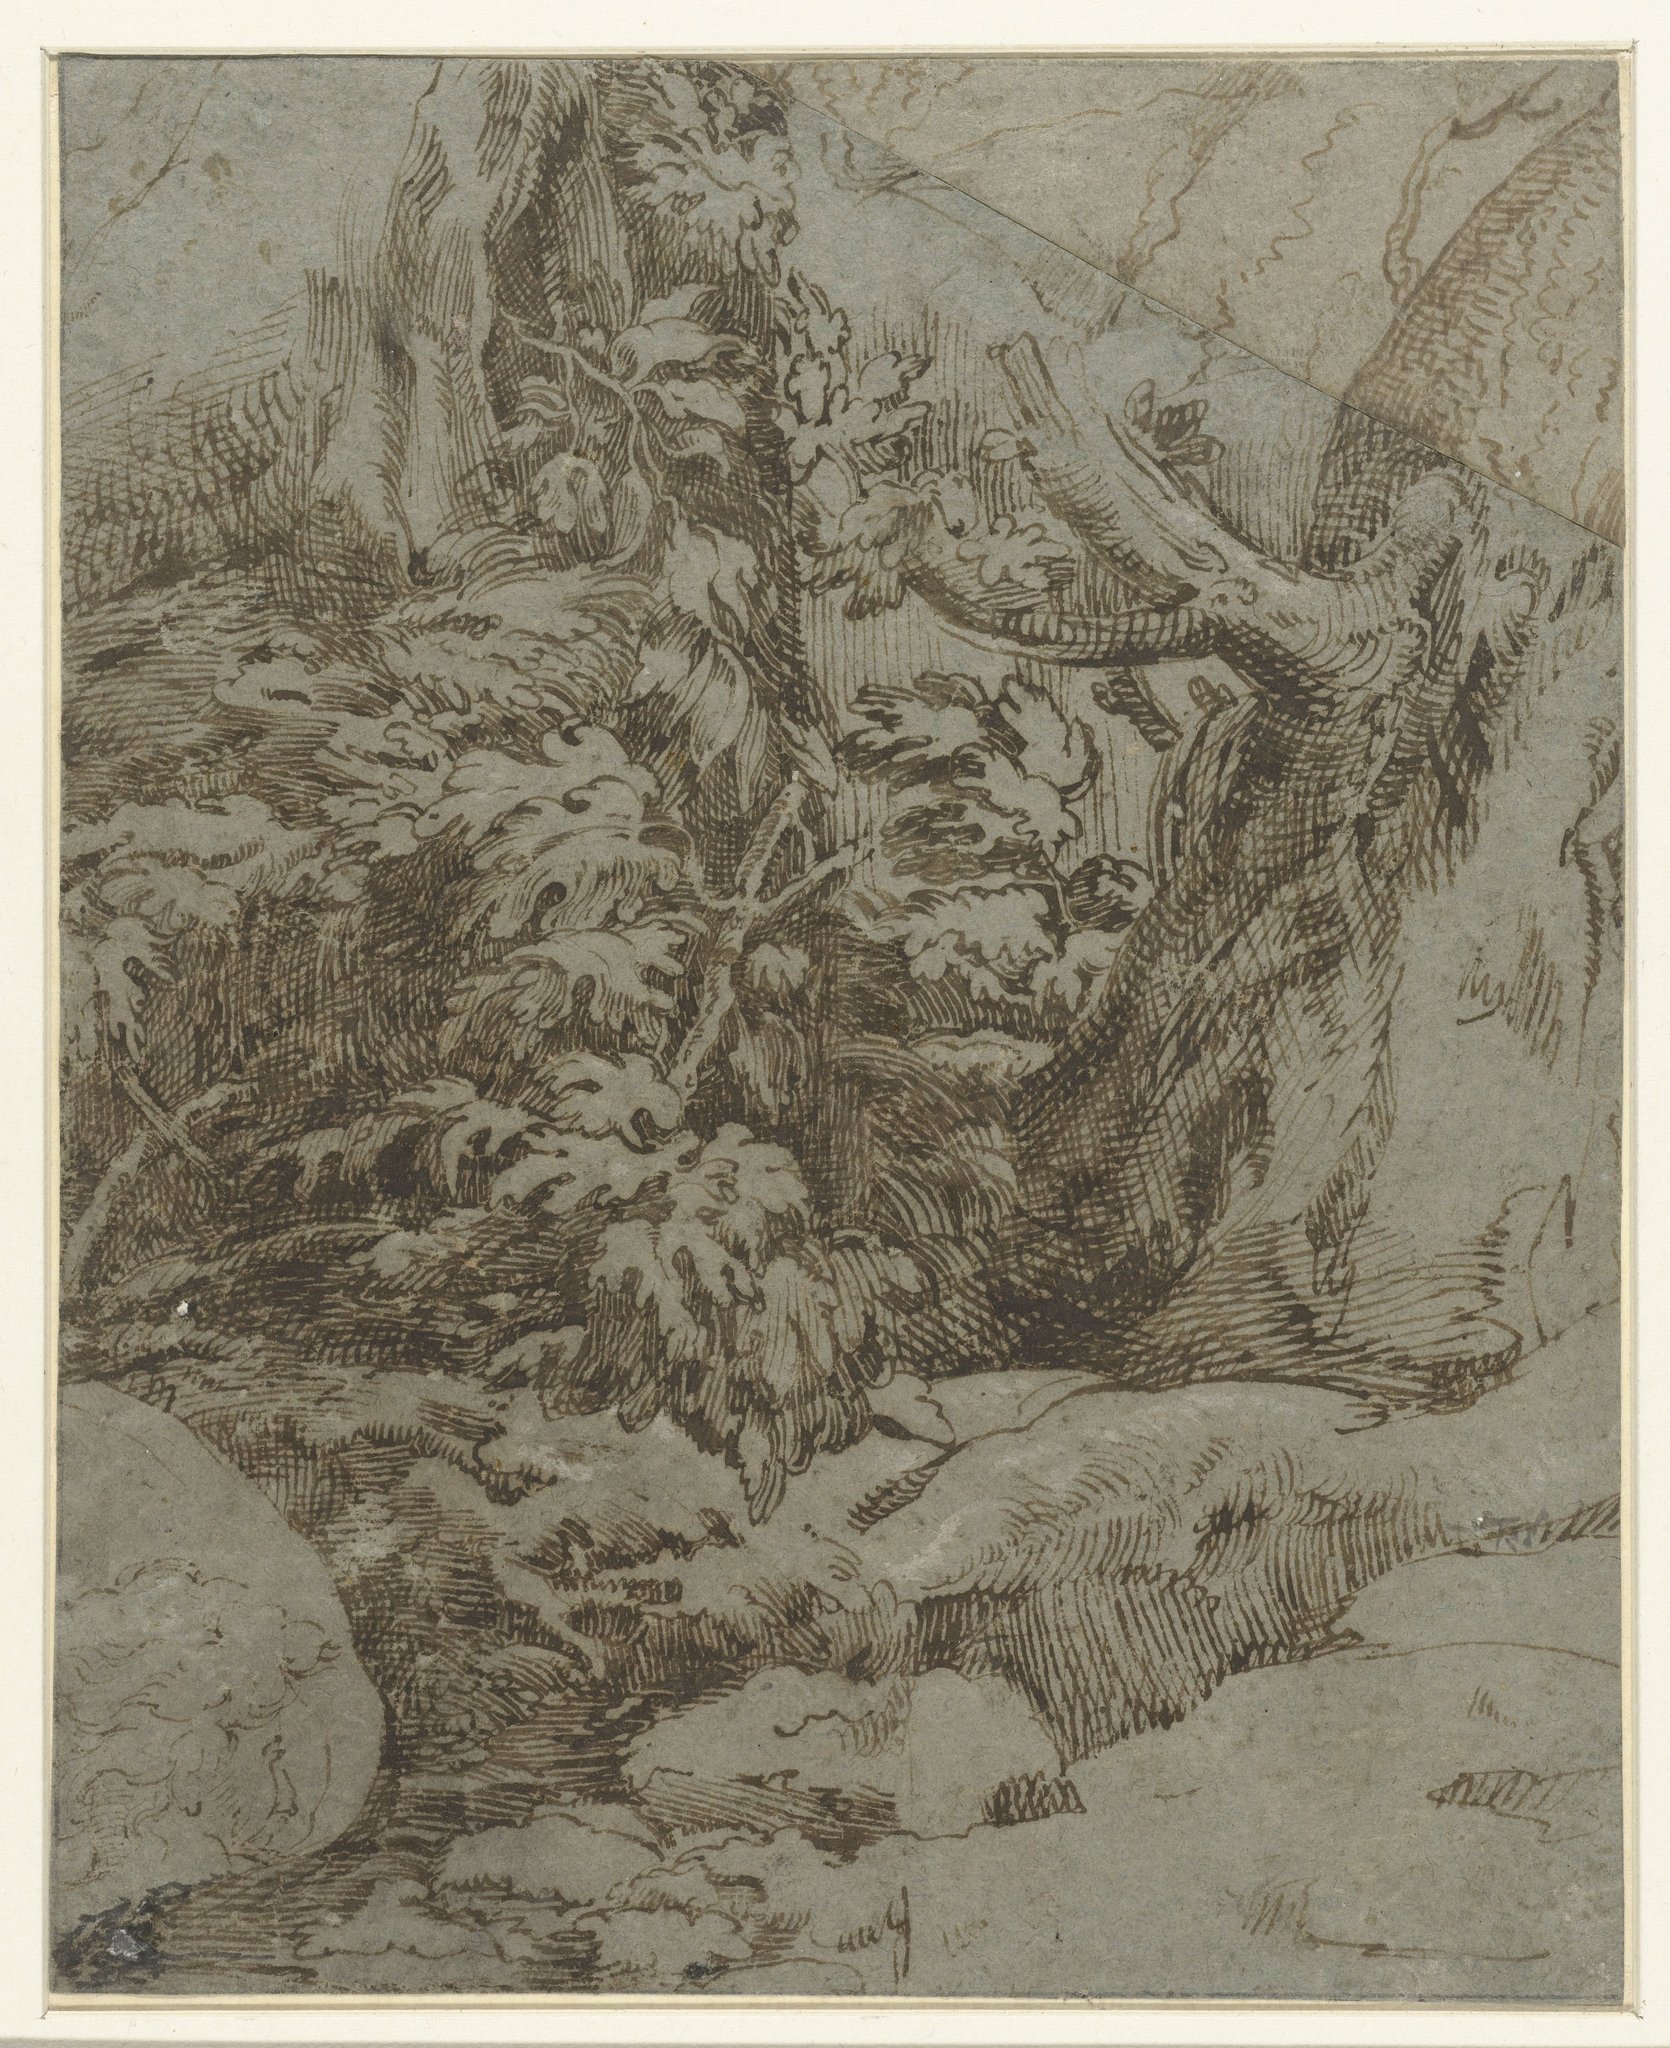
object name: design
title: Studie van een landschap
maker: parmigianino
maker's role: draughtsman, painter, print maker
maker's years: 1503-1540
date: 1524-1528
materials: ink, paper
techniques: brush, pen